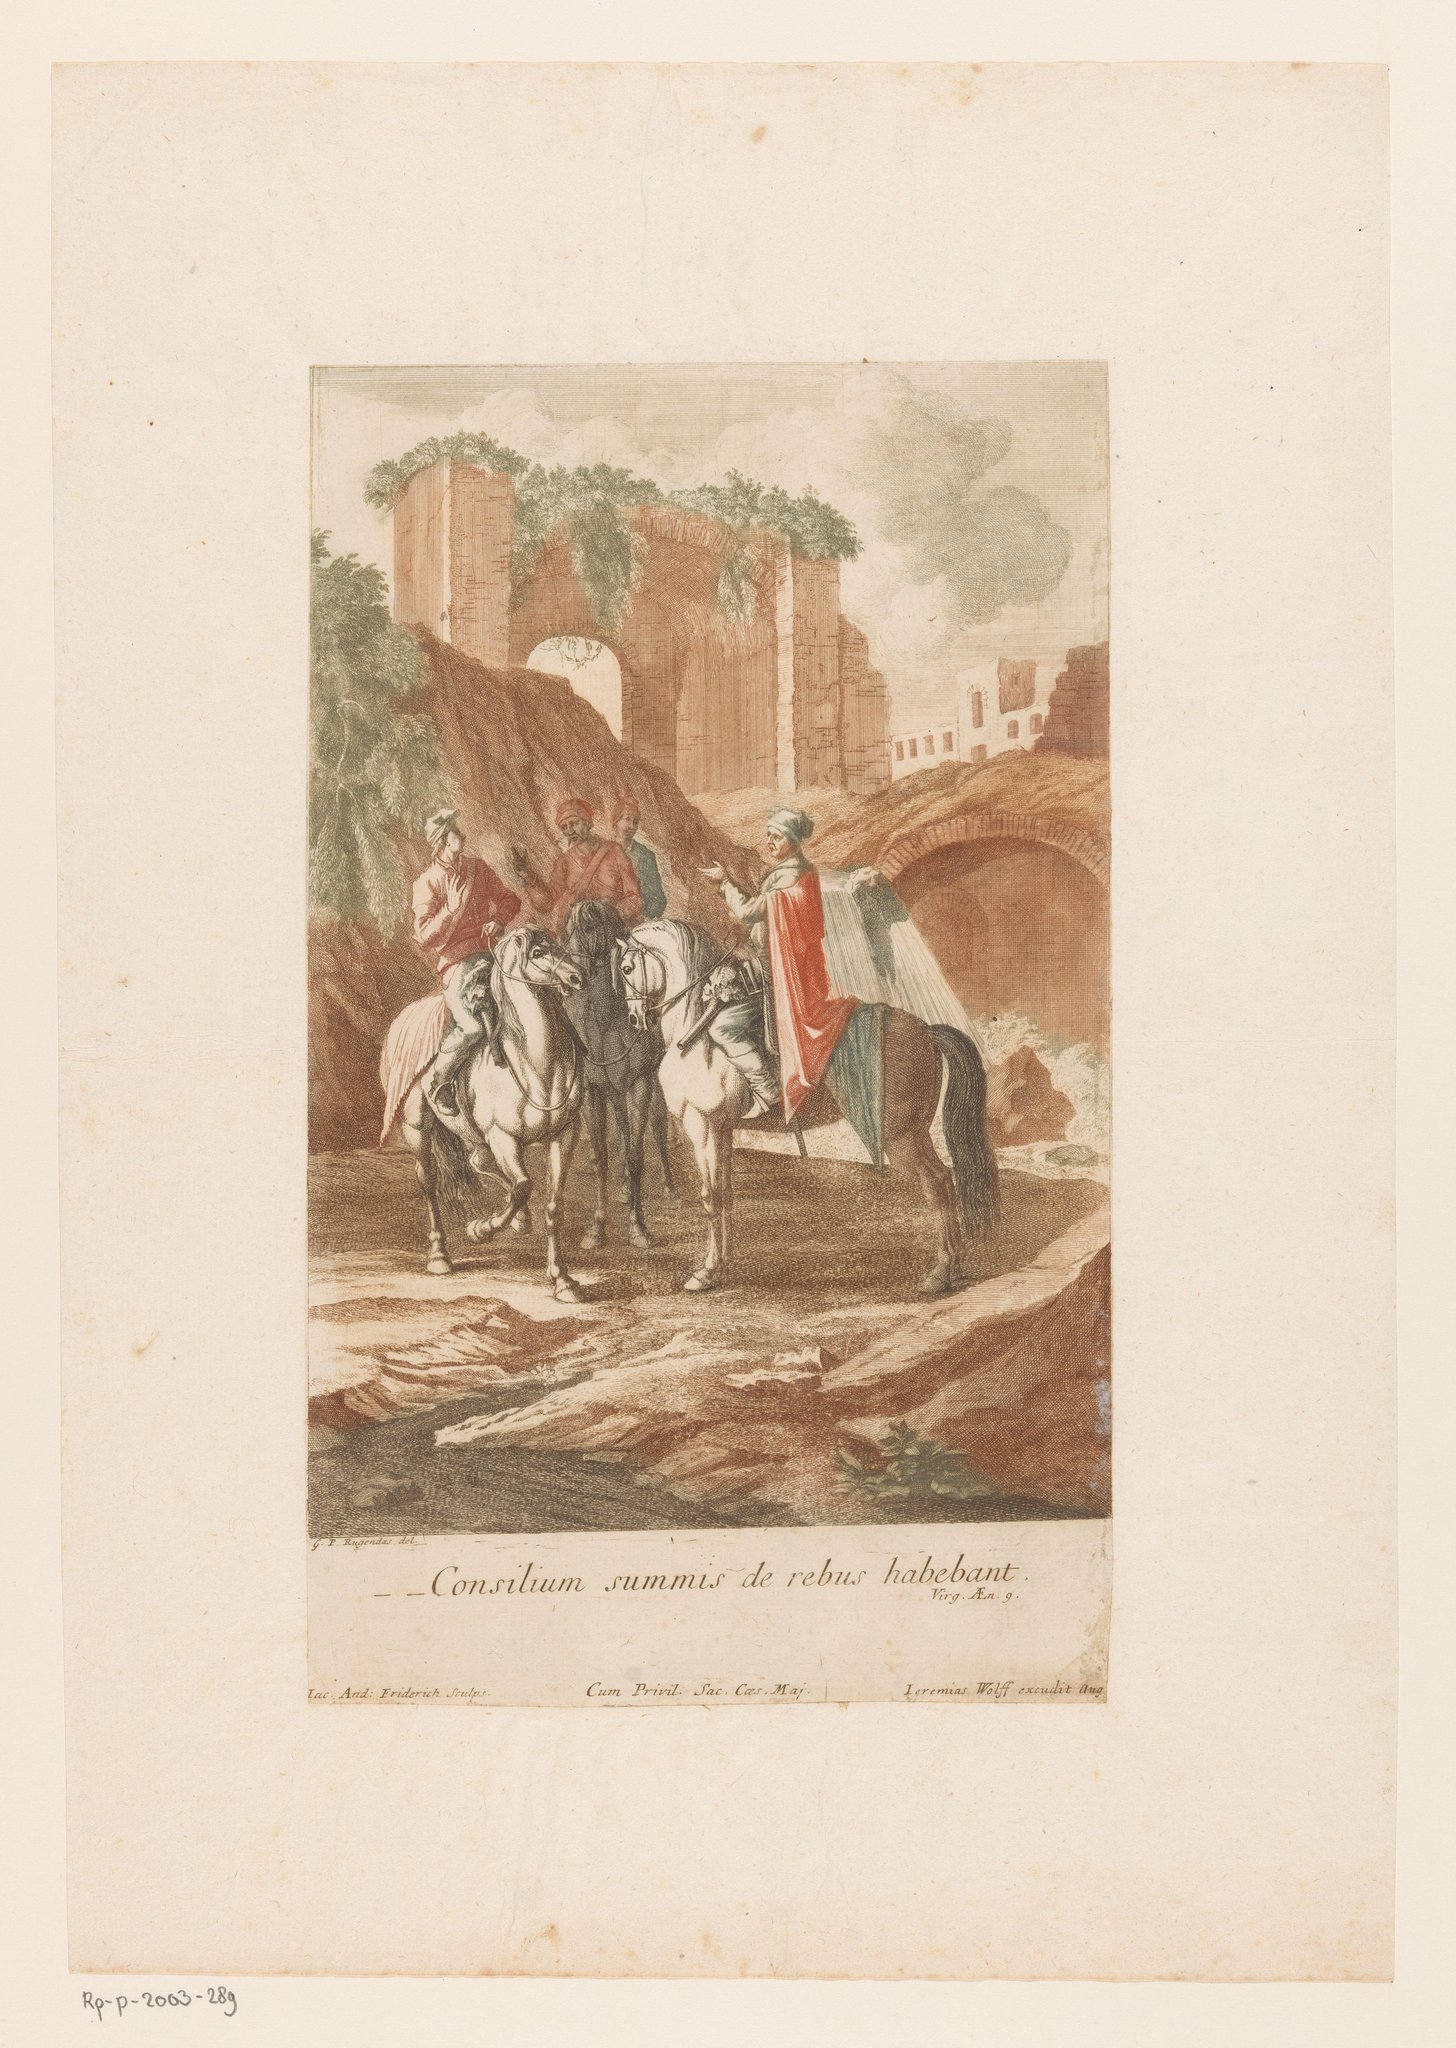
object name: print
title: Nachtelijk overleg van aanvoerders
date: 1694-1724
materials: paper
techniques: engraving, etching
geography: holy roman empire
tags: the trojans reach the mouth of the tiber and land in latium (virgil, aeneid vii-viii)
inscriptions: collector's mark: Lugt 2760, collector's mark: Lugt 2228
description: Onderdeel van een serie prenten over het, door Vergilius geschreven verhaal van Aeneas (Virg. Aen. 9).